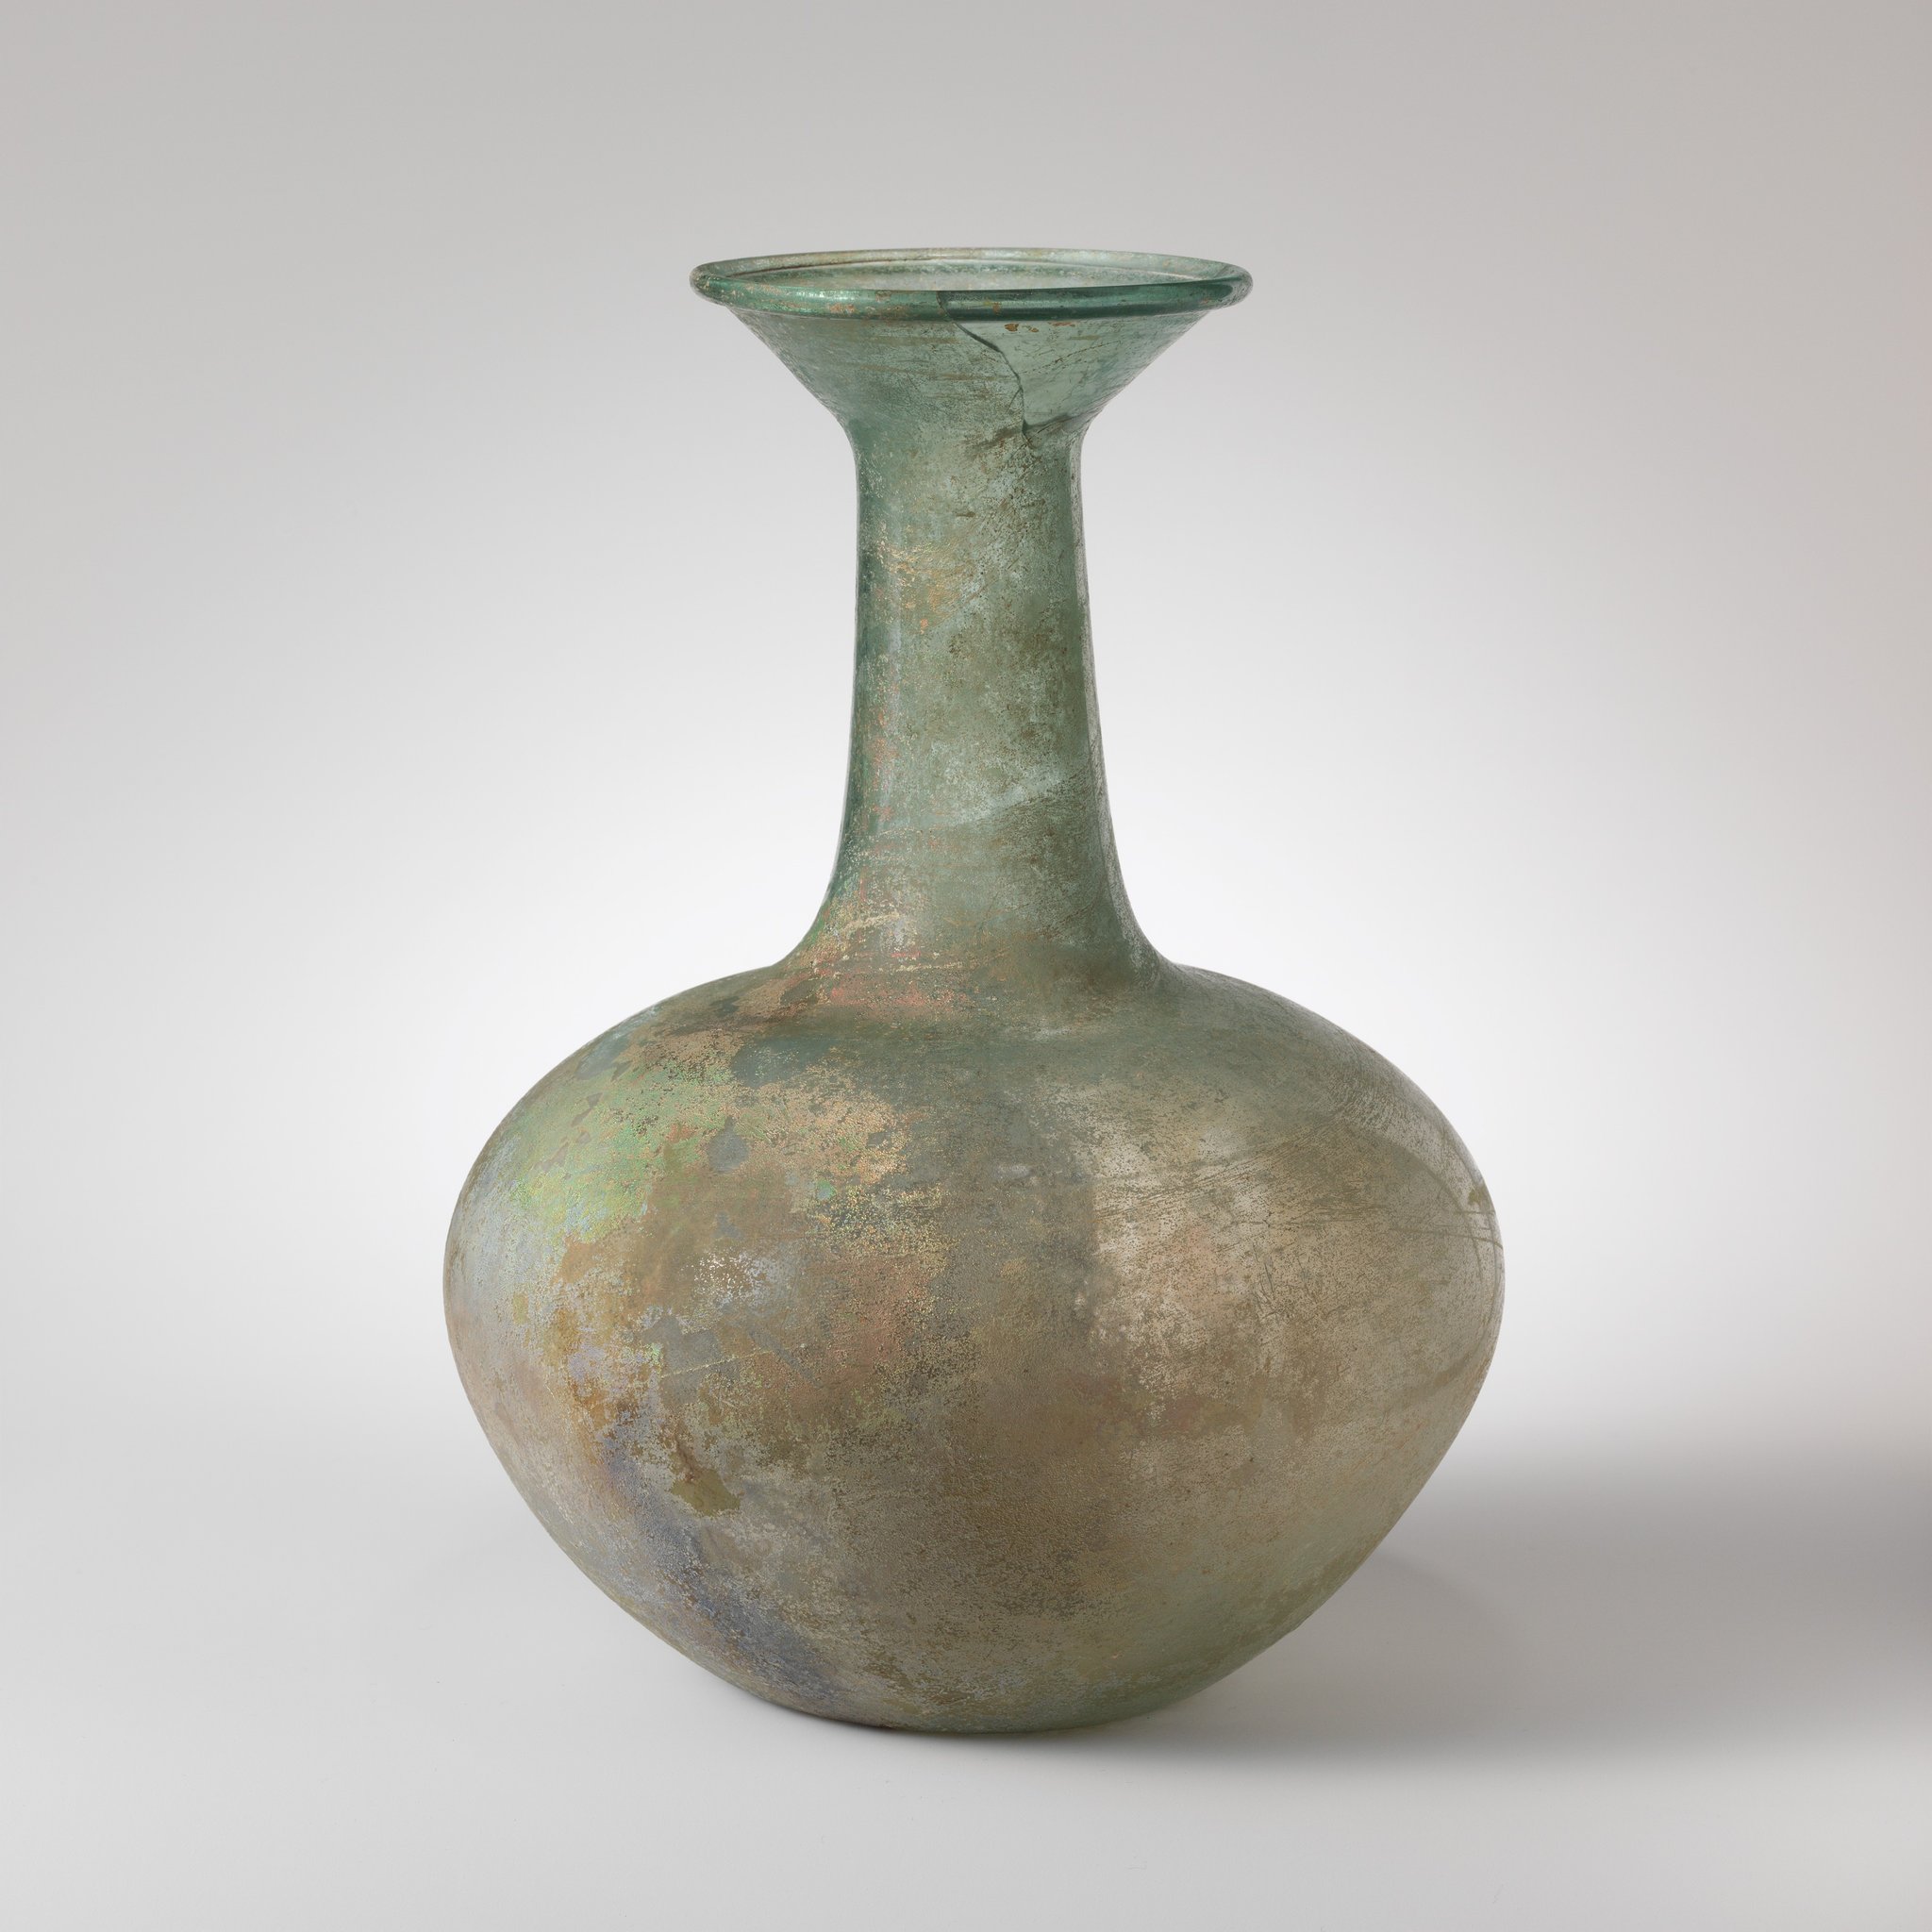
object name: bottle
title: Glass bottle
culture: roman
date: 301-500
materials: glass